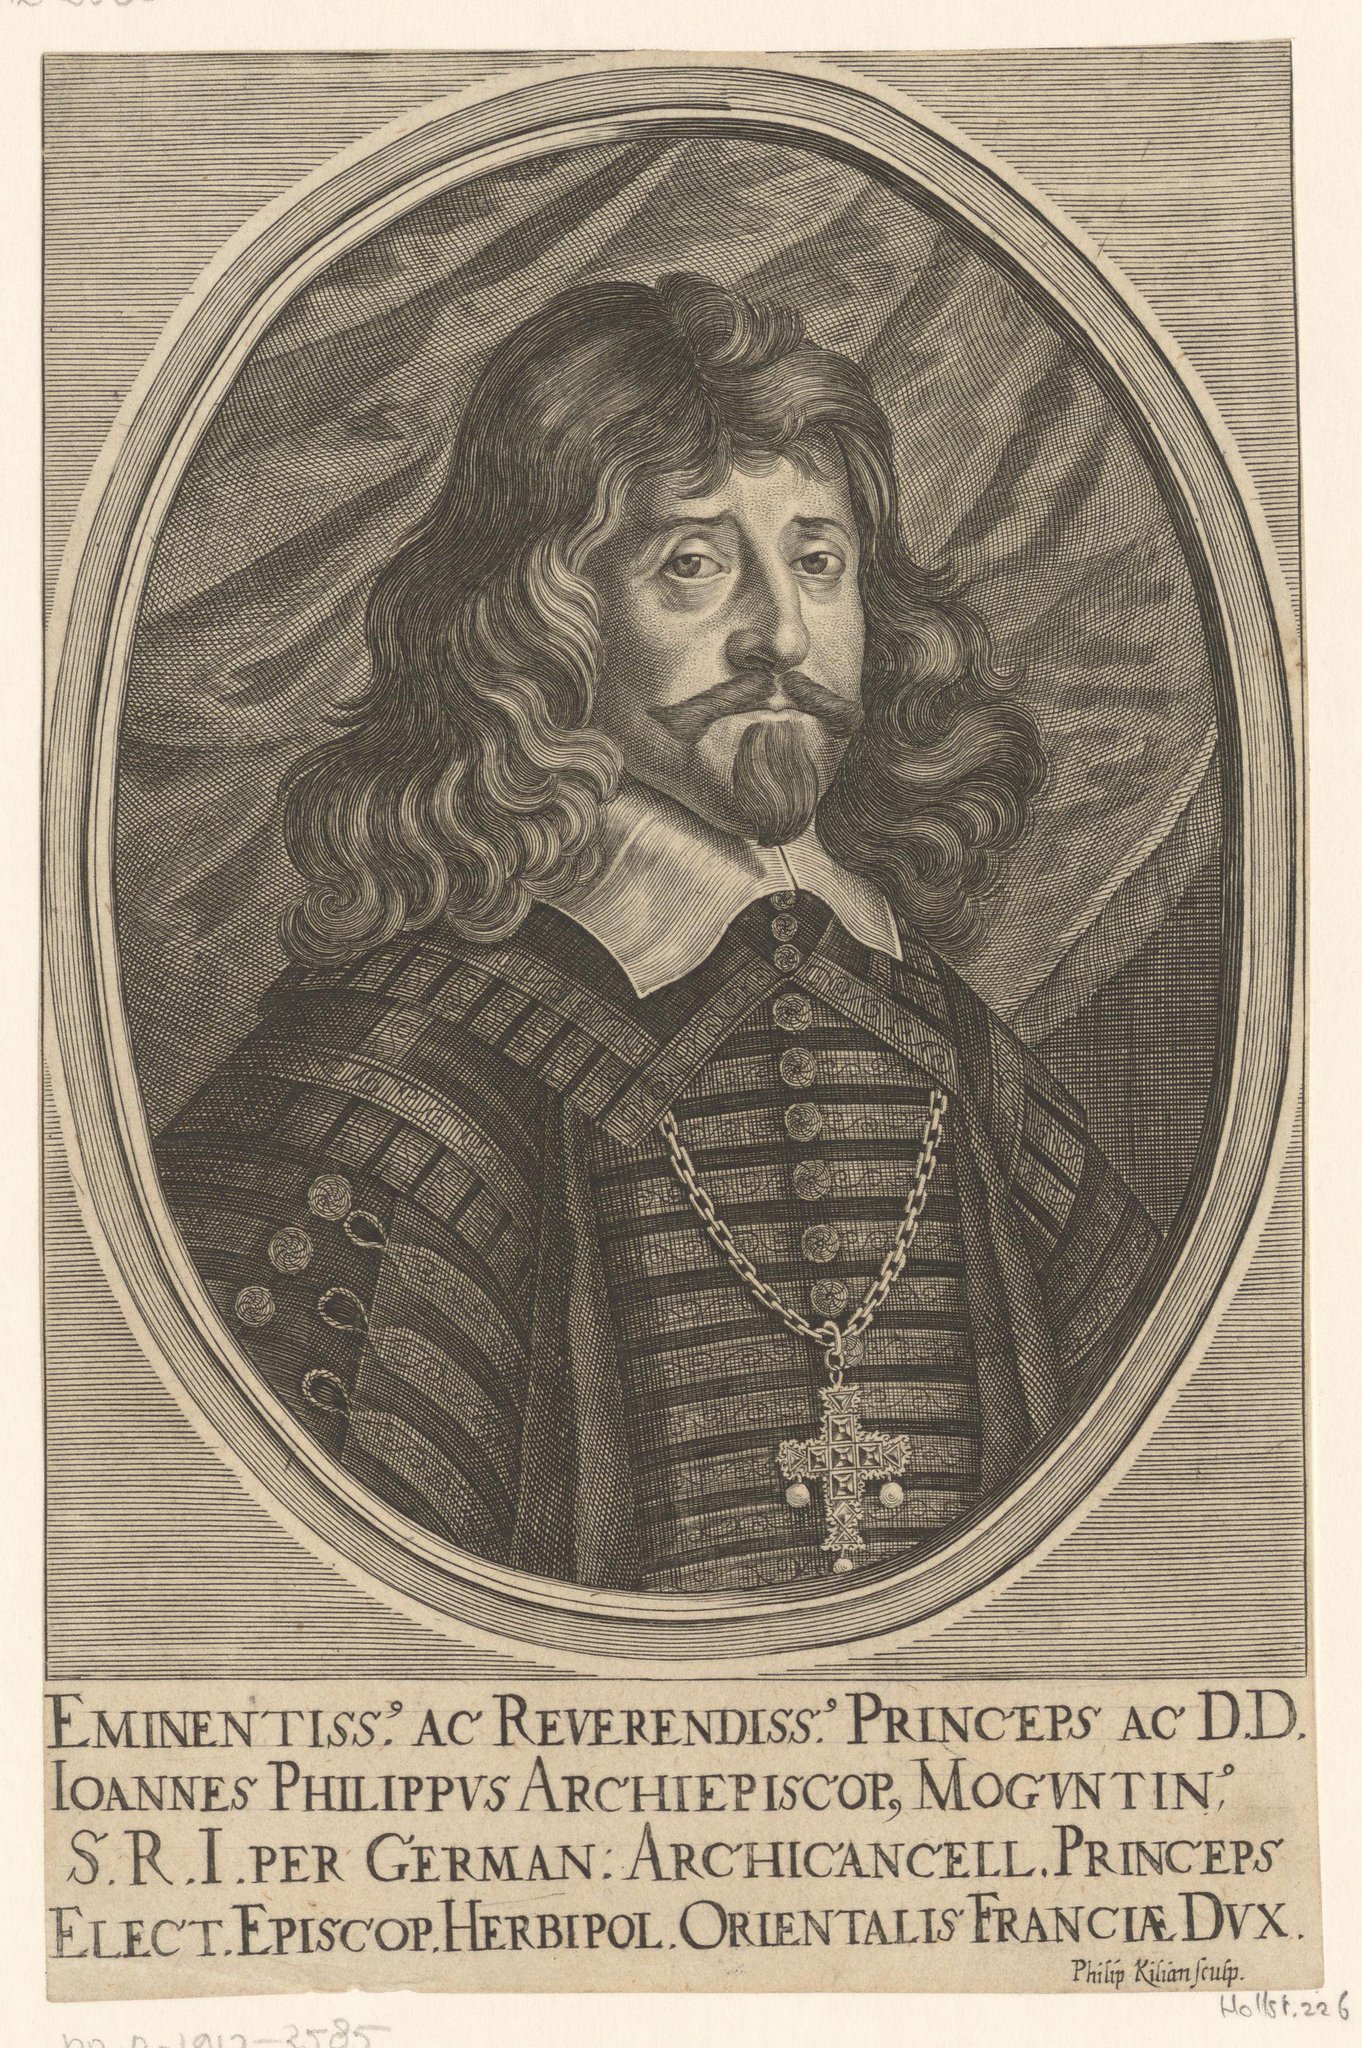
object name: print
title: Portret van Johann Philipp von Schönborn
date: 1638-1693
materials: paper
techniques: engraving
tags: archbishop, bishop, etc. (roman catholic), historical persons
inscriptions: collector's mark: Lugt 2228